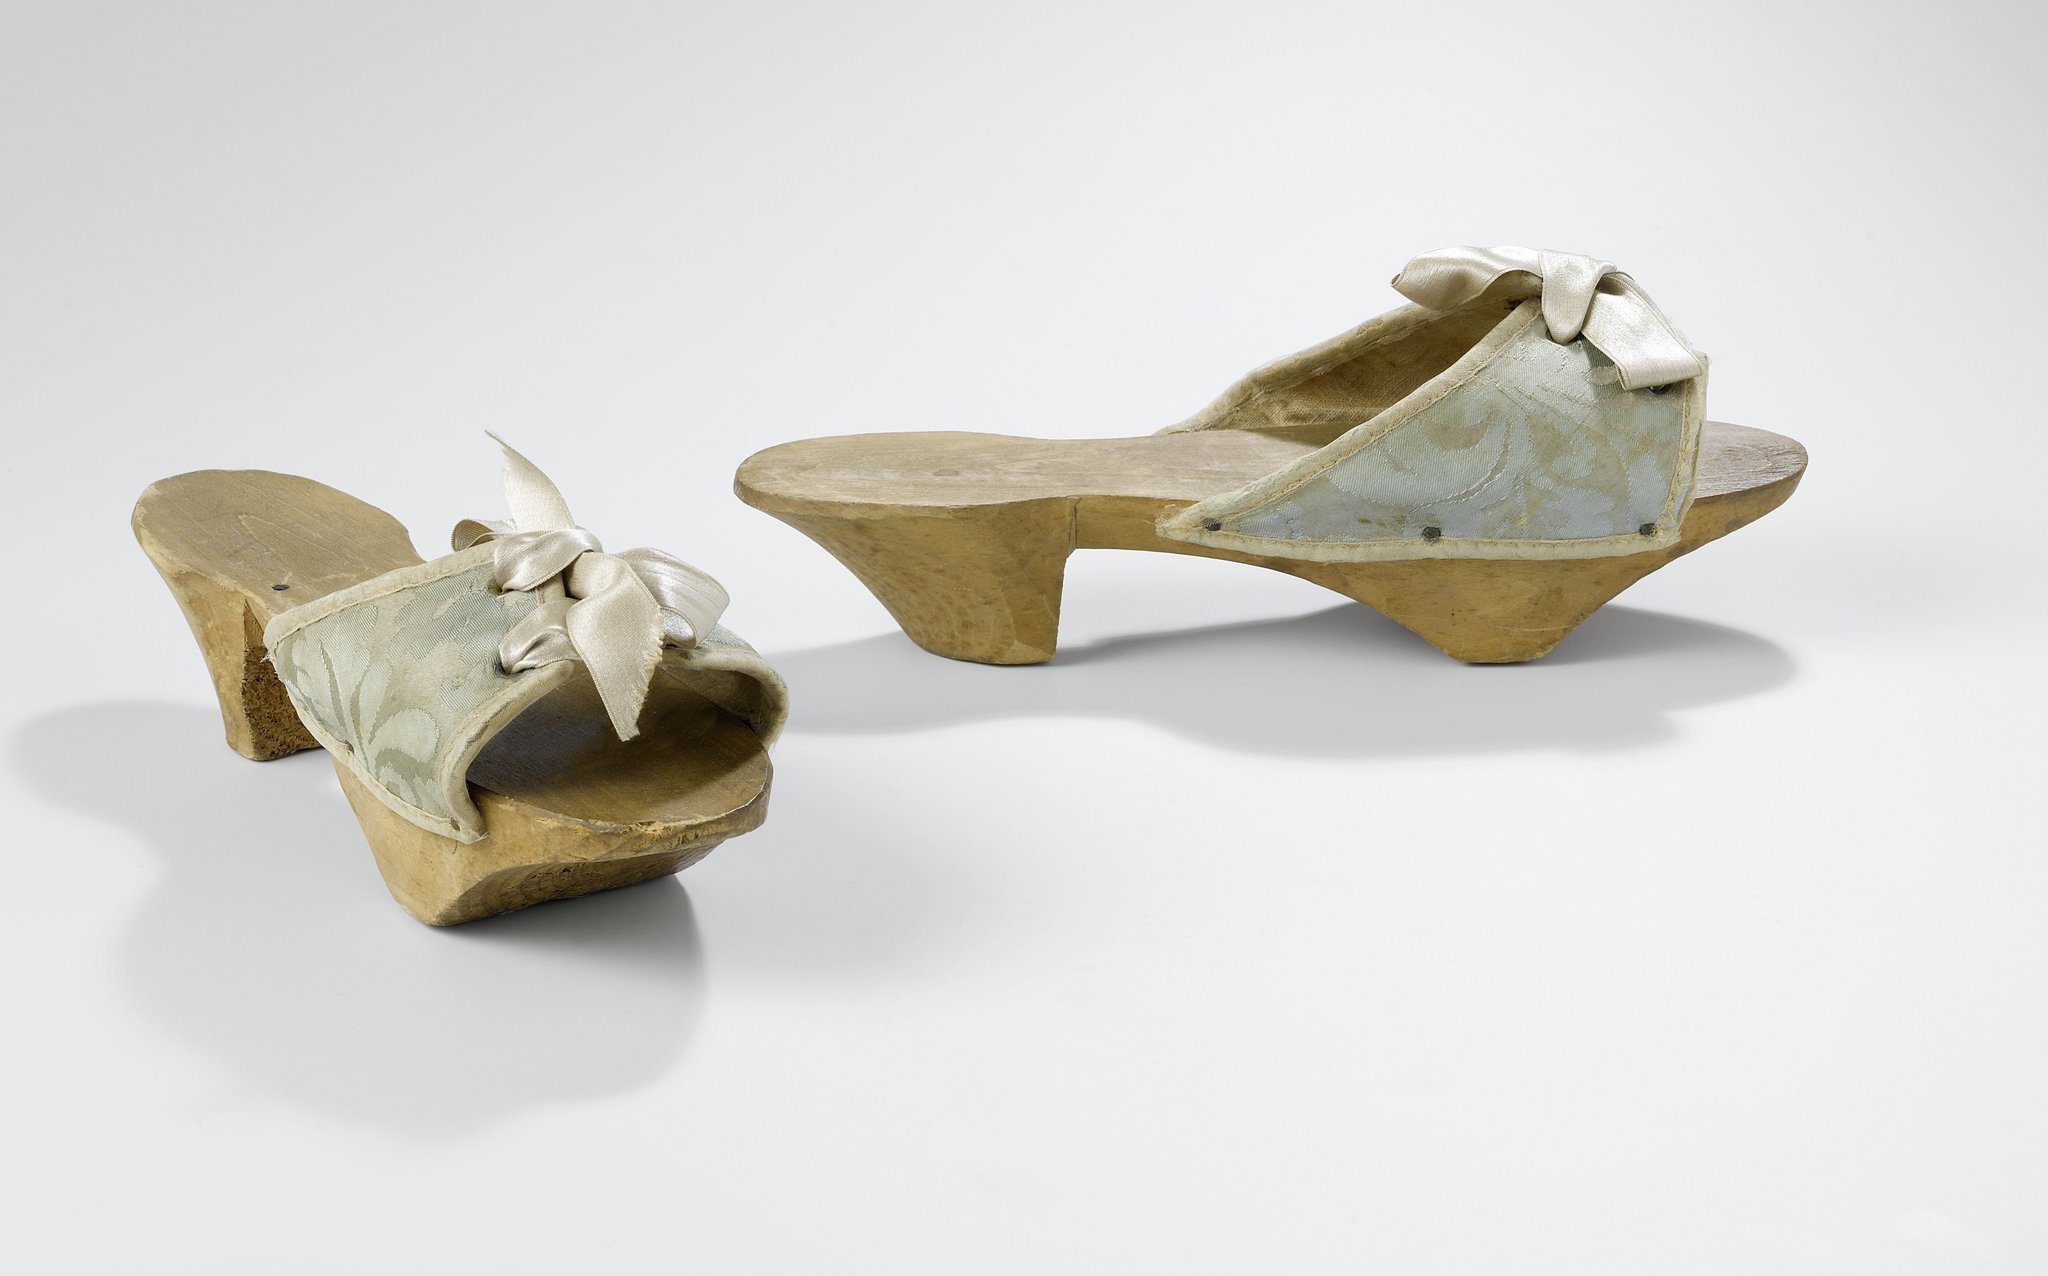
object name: overshoe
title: Pair of pattens, or overshoes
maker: Anonymous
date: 1700-1760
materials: iron, linen, metal, silk, wood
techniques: cutting, weave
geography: netherlands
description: Overschoen of "patijn" van blank hout met een tweedeling voorblad van lichtblauw zijden damast. Model: Zool van blank hout met afgeronde neus. Vanaf de neus loopt het hout in een afgeronde curve naar beneden. Na een plateau op de grond loopt het hout in een afgeronde curve richting het geleng. De voorkant van de hak loopt recht naar beneden. De zijkant en achterkant van de hak lopen in een afgeronde curve naar beneden. De twee delen van het voorblad zijn met drie spijkers per kant vastgeslagen in het hout. Het voorblad begint halverwege de voorvoet en zijn in een rechte lijn met elkaar verbonden. Het voorblad loopt bij de wreef in een ronde bocht richting het geleng waar het is vastgezet in de houten zool. Het voorblad is gevoerd met beige linnen. Versiering: In de tekening van het damast zijn bloemachtige vormen te zien. De twee delen van het voorblad hebben beide twee metalen vetergaten. Door de vetergaten is een ivoorkleurig zijden lint geregen die de twee delen van het voorblad bij elkaar houdt. Afgebiesd met ivoorkleurige zijde.